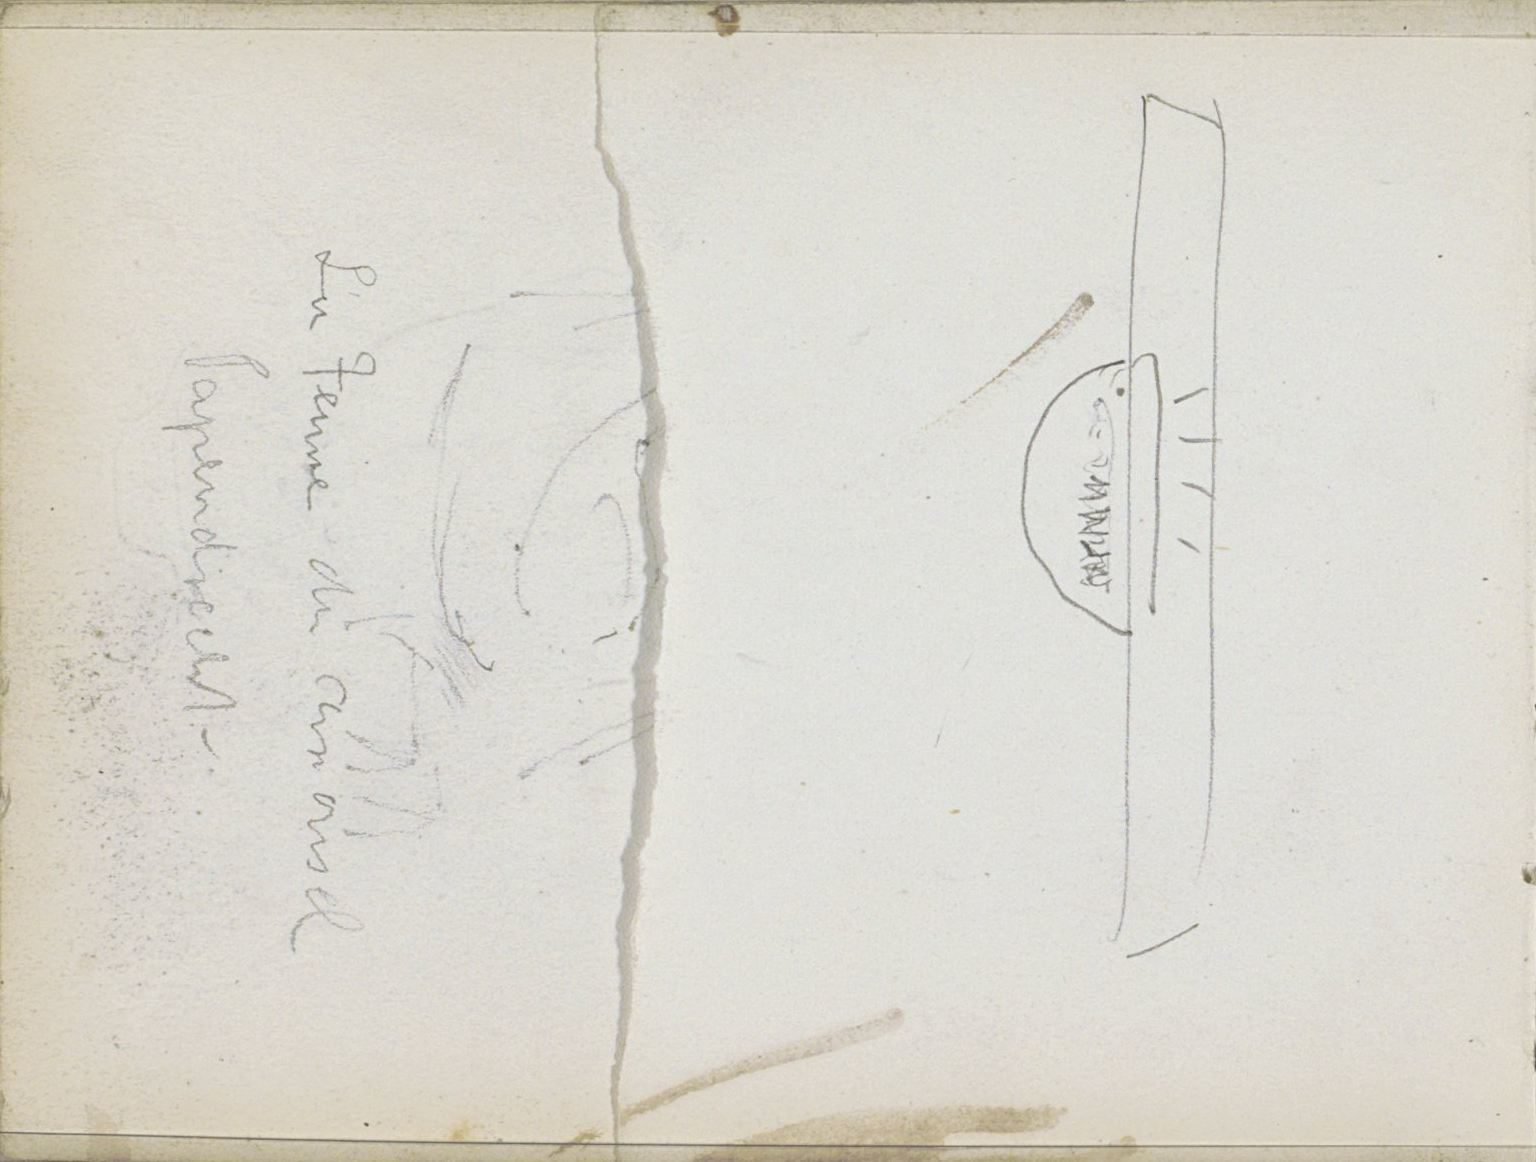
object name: sketchbook leaf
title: Rechthoek met een halve cirkel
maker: george clausen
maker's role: draughtsman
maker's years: 1852-1912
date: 1874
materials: paper, pencil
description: Mogelijk een boot of hoed. Blad 25 verso uit een schetsboek met 37 bladen.